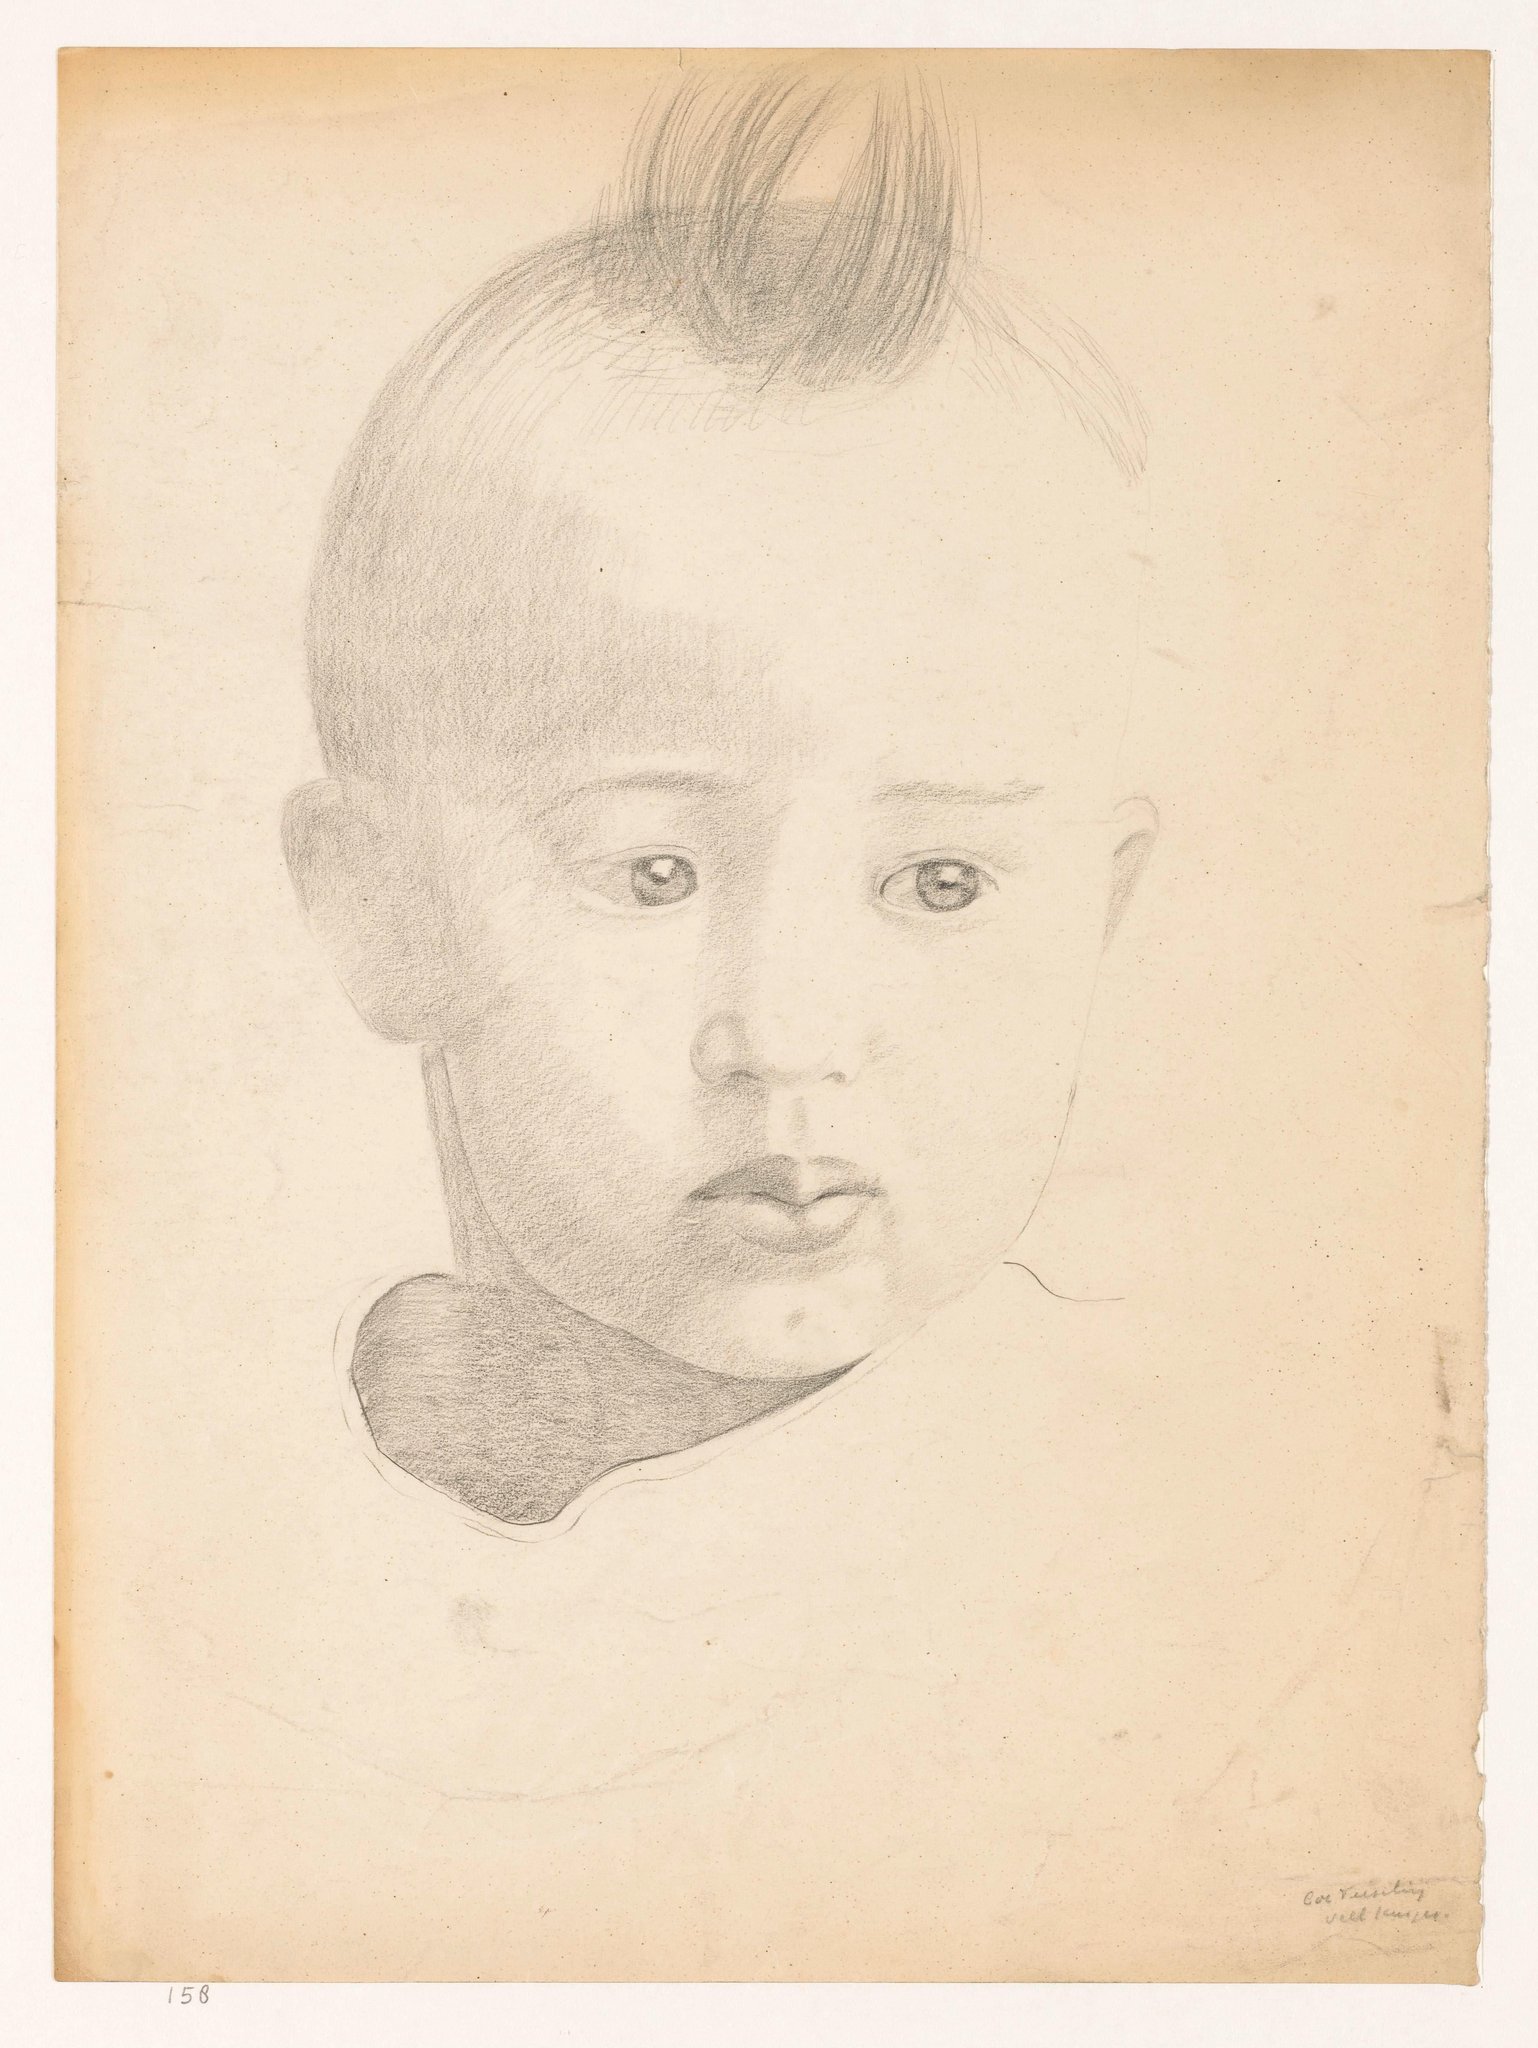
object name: drawing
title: Kinderkopje met een rechtopstaand plukje haar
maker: cor van teeseling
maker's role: draughtsman, sculptor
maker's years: 1915-1942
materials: paper, pencil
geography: amsterdam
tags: amsterdam, draughtsman, sculptor, cor van teeseling, netherlands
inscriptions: inscription: ‘veel kusjes Cor Teeseling’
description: Kinderkopje met een rechtopstaand plukje haar.